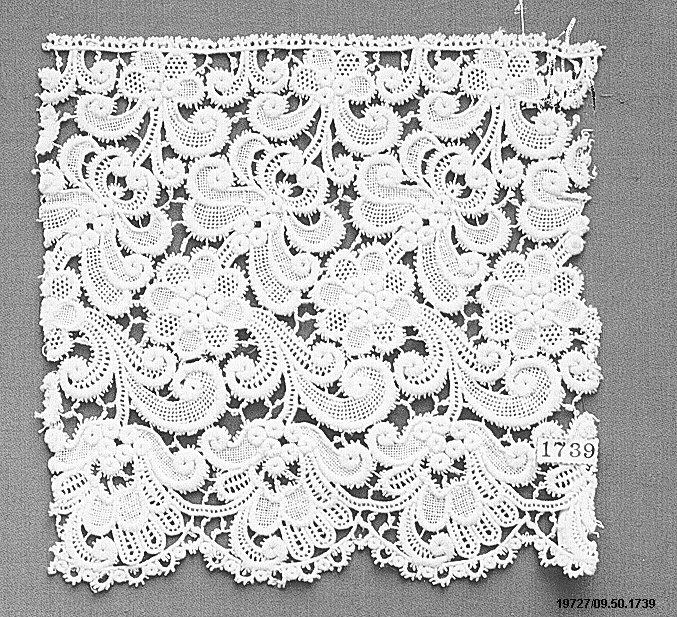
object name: fragment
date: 1801-1900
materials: lace